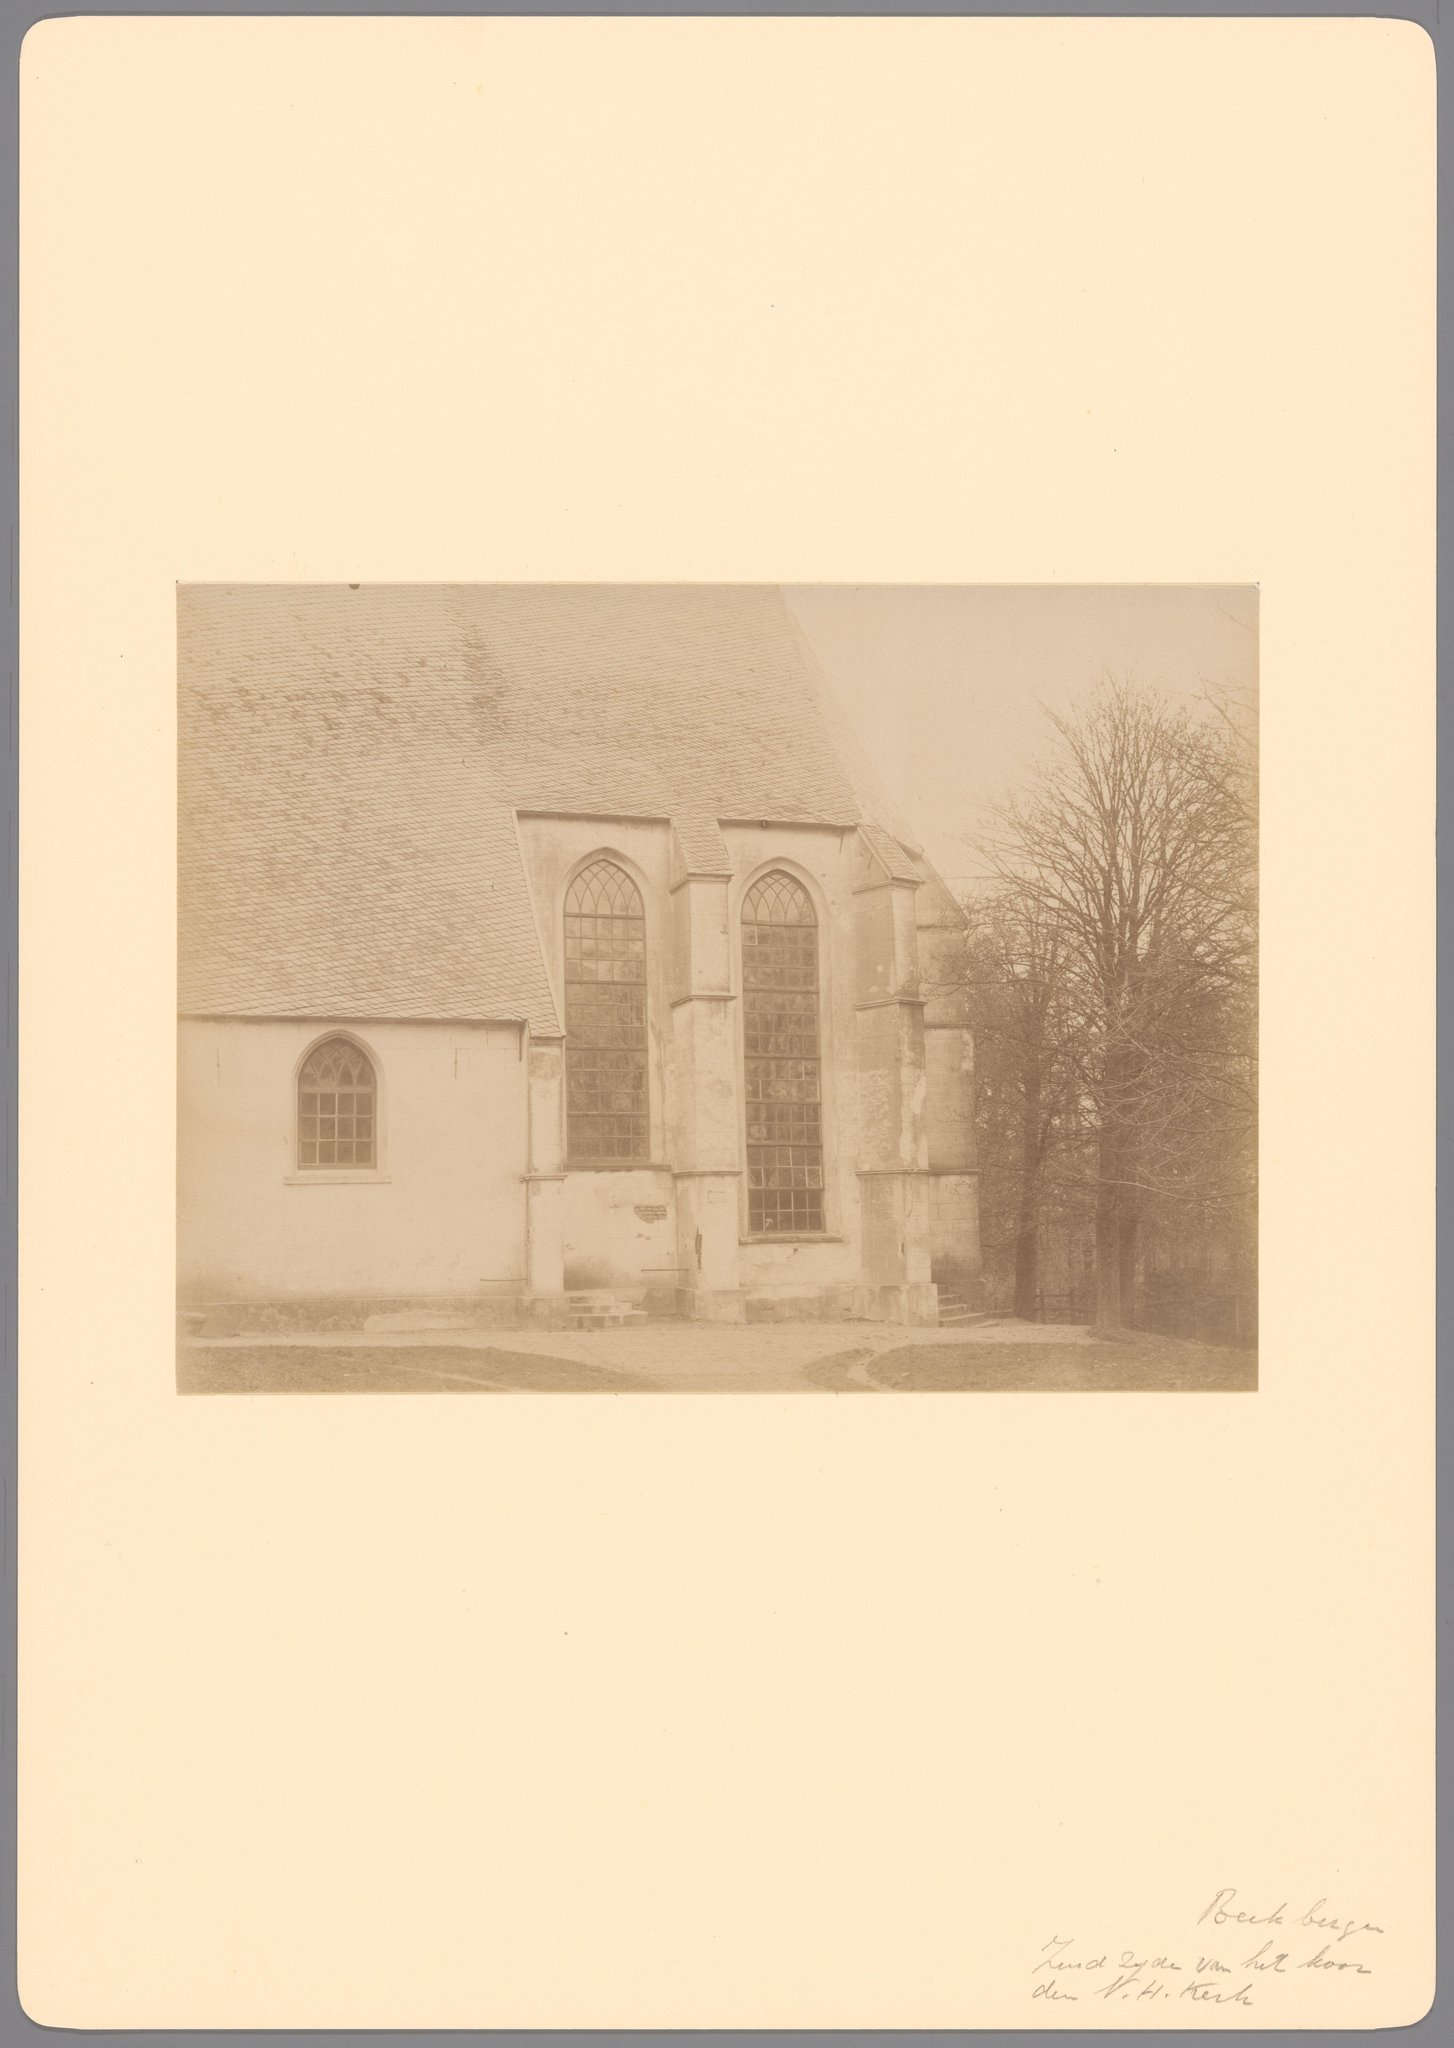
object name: photograph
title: Gezicht op het koor van de Hervormde Kerk te Beekbergen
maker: anoniem (monumentenzorg)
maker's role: fotograaf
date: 1897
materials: cardboard, photographic support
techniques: albumen print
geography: beekbergen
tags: parts of church exterior and annexes: choir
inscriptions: annotation: ‘Beekbergen/ Zuidzijde van het koor der N.H. Kerk’